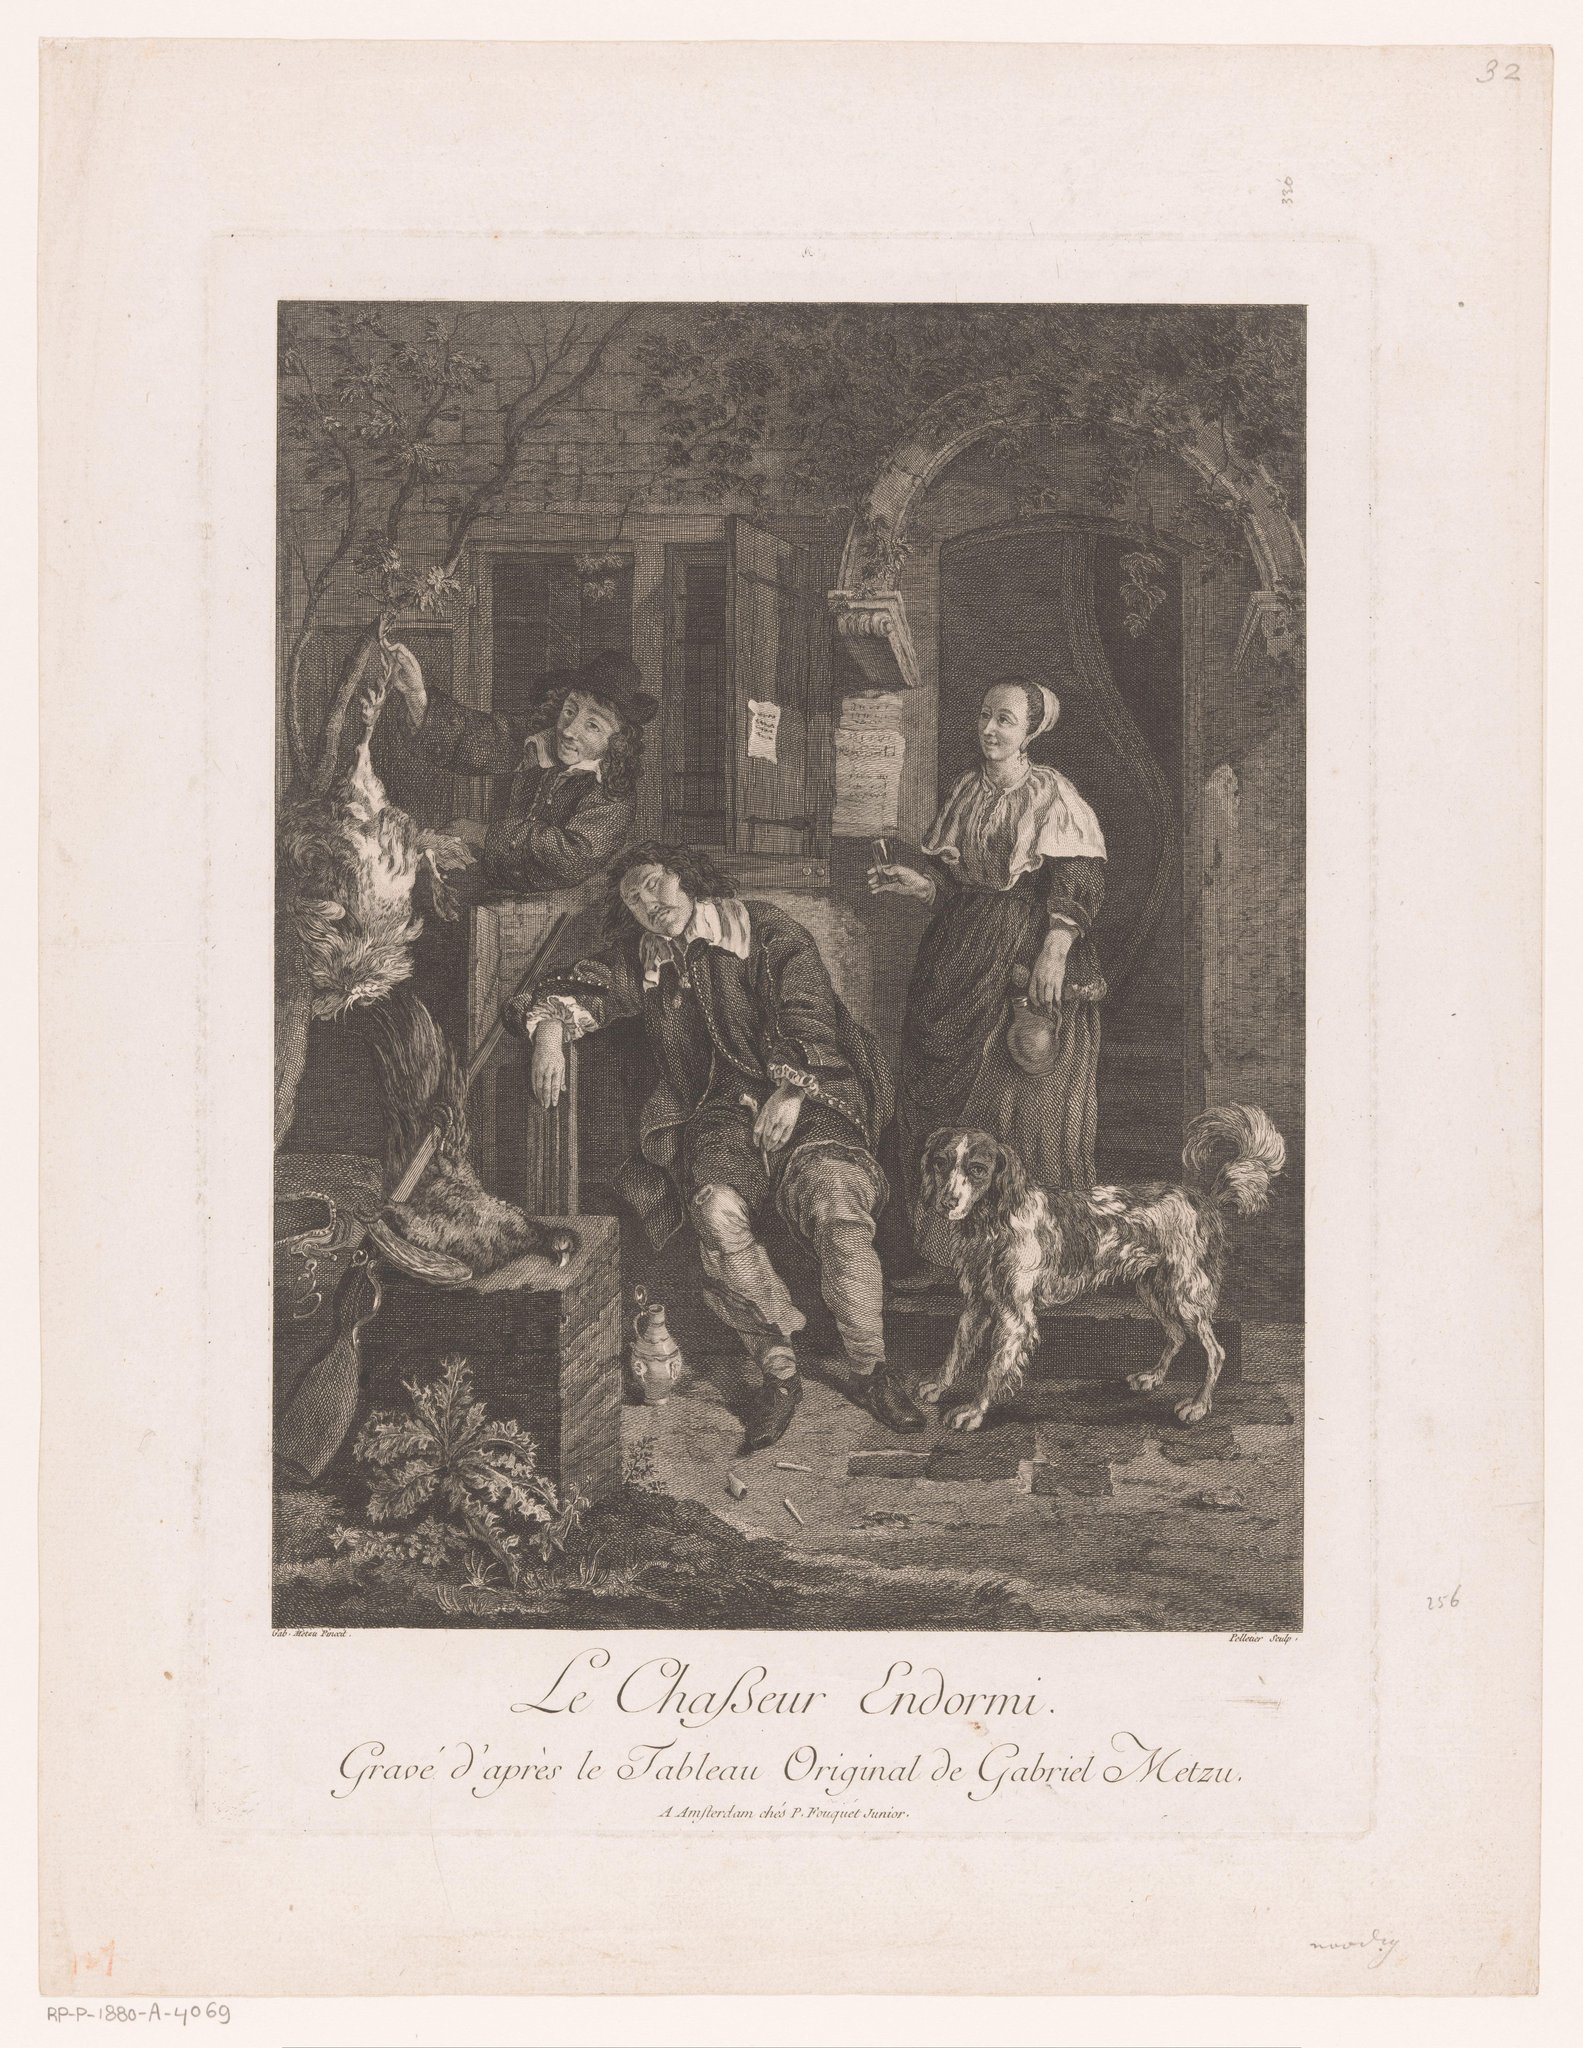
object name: print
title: Le Chasseur Endormi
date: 1750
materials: paper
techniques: engraving, etching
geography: amsterdam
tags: hunter, dog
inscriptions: collector's mark: Lugt 2228